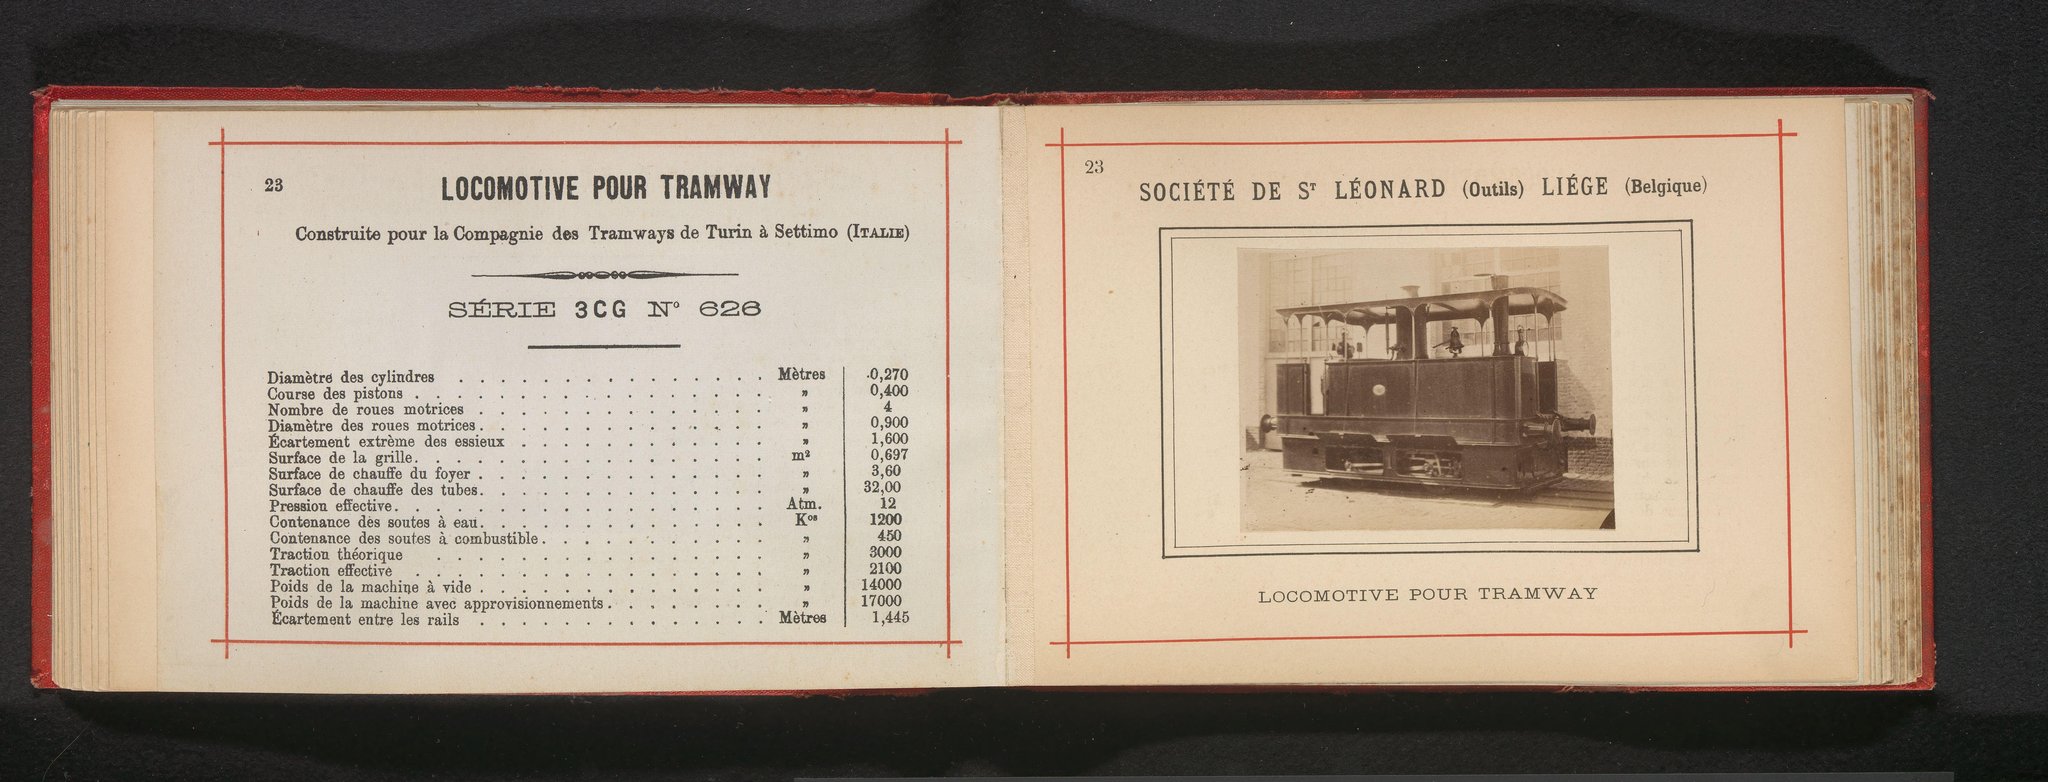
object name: page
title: Locomotive pour tramway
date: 1880-1885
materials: photographic support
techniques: albumen print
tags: locomotive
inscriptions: inscription: ‘Société de St. Léonard (Outils) Liége (Belgique)’